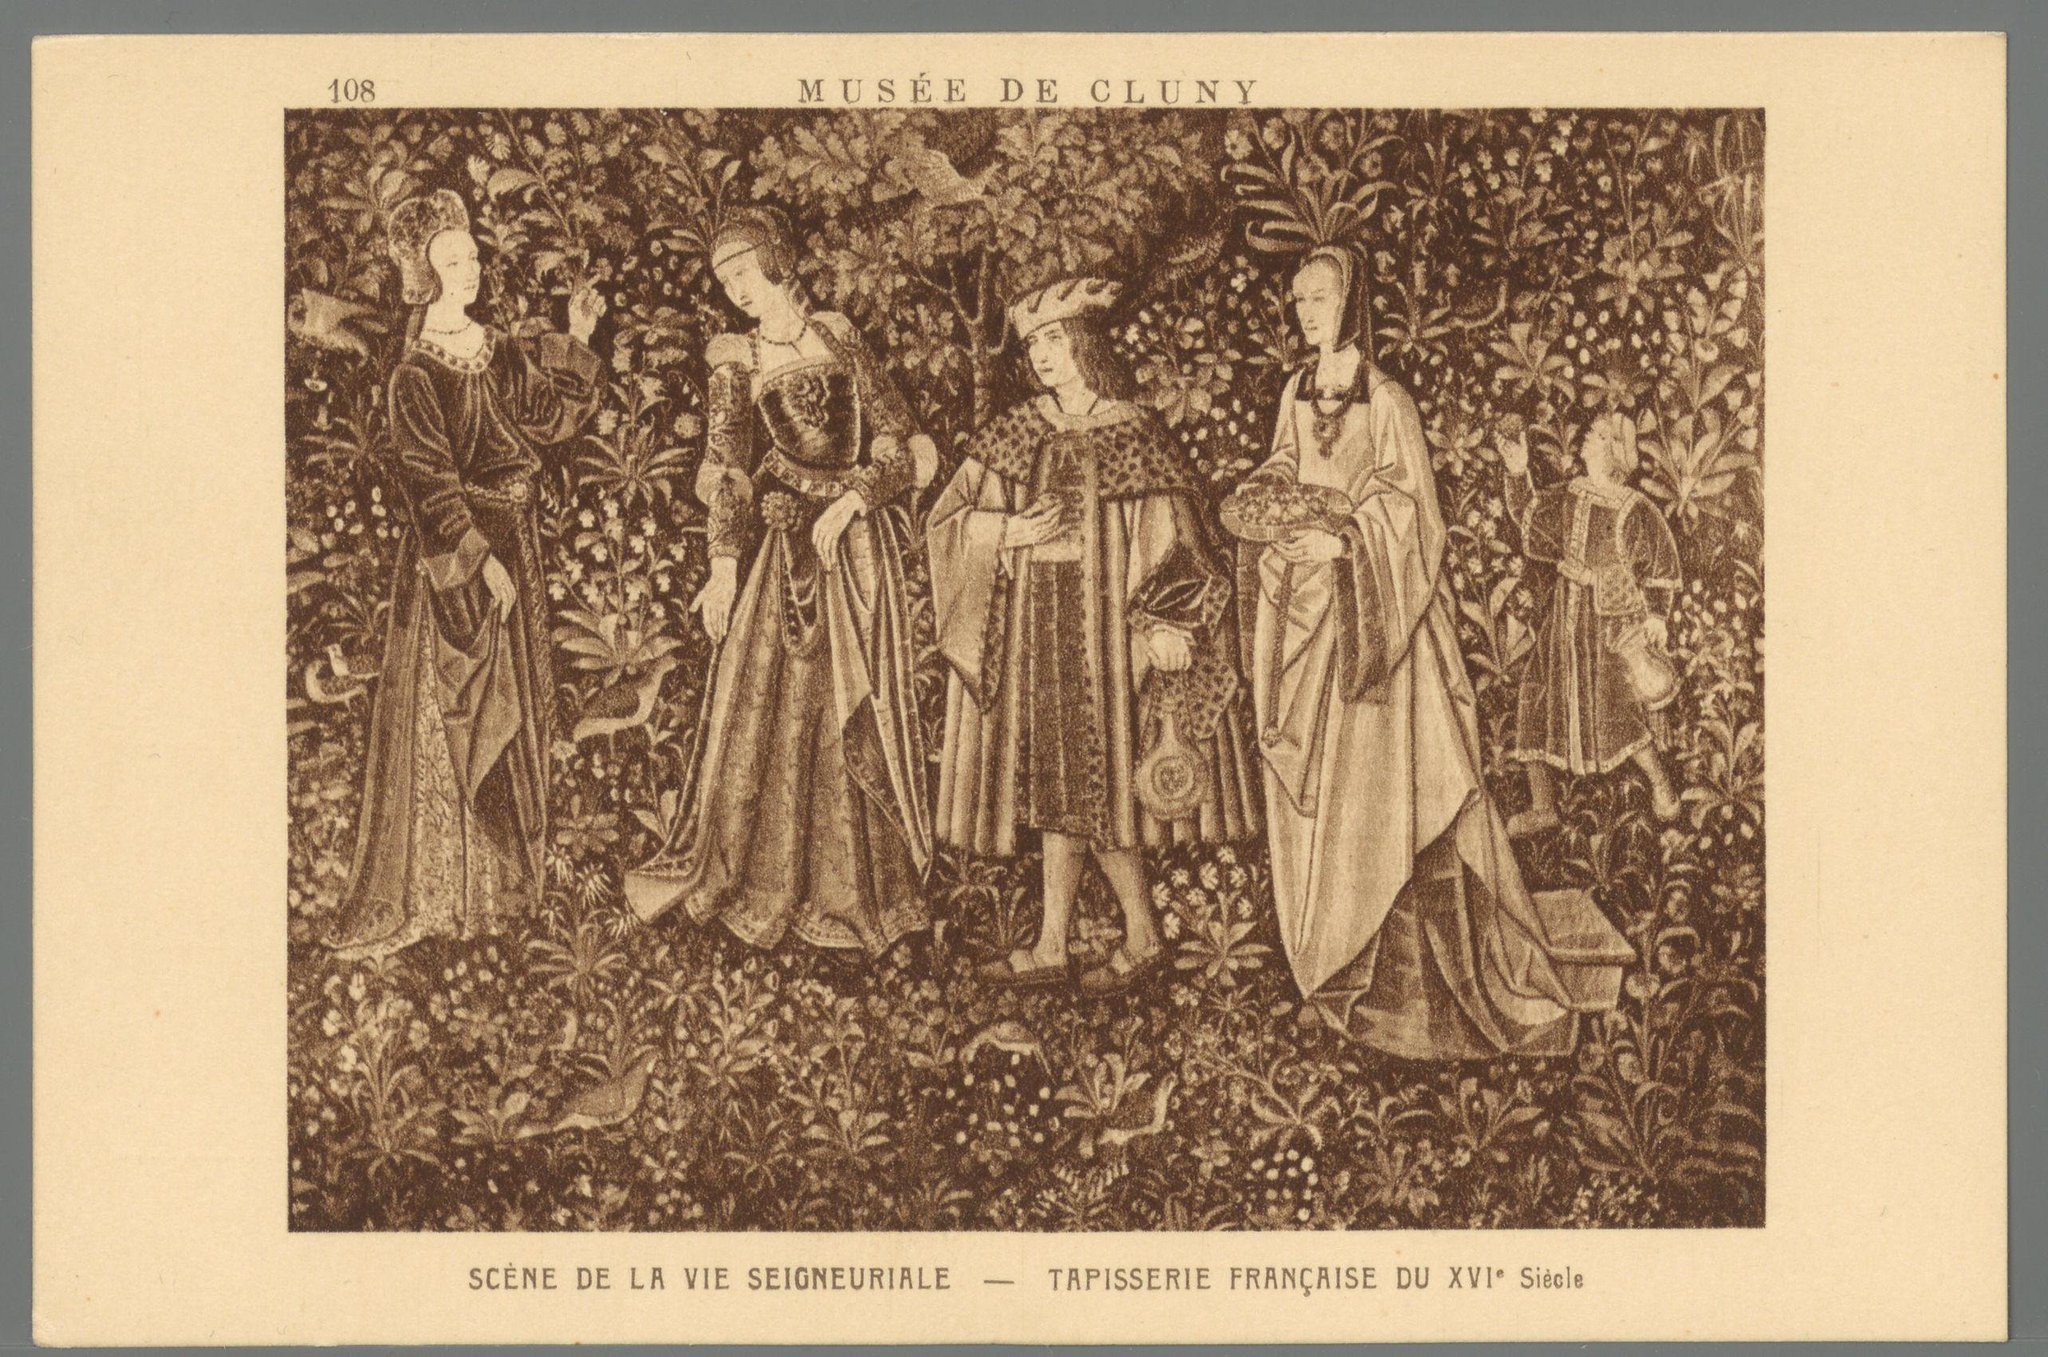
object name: photomechanical print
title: Musée de Cluny. Scène de la vie seigneuriale - Tapisserie Française du XVIe Siècle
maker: Anonymous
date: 1903-1930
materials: cardboard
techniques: rotogravure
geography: paris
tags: permanent exhibition, museum, tapestry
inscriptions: collector's mark: ‘AFE v S’